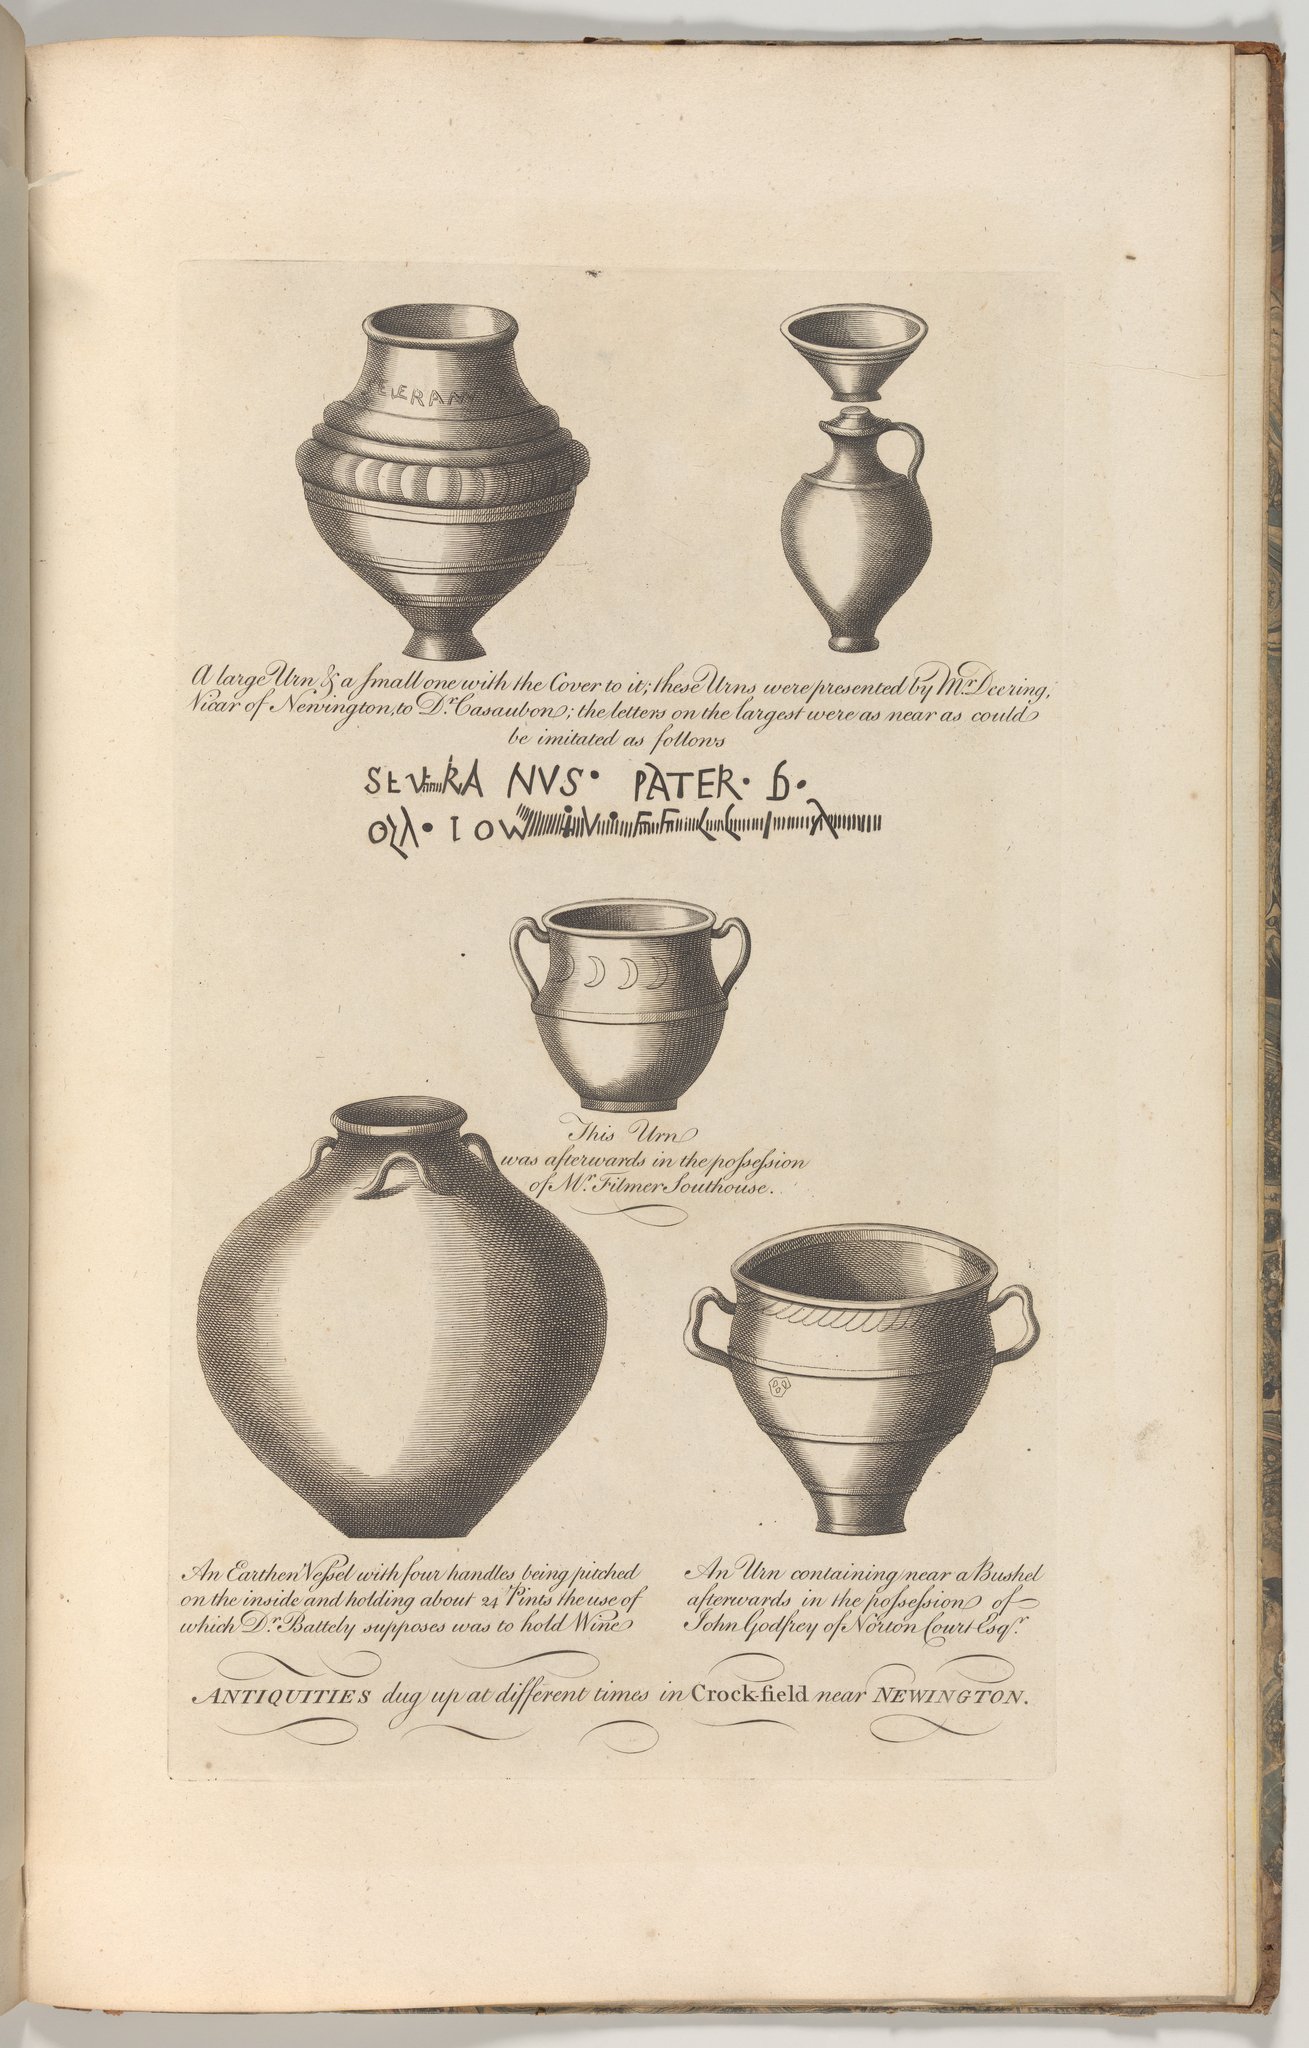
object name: print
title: Leeds Castle in the County of Kent, from Edward Hasted's "The History and Topographical Survey of the County of Kent", vols. 1-3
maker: richard bernard godfrey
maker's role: artist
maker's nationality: british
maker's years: 1728-1795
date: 1777-1790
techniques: engraving, etching